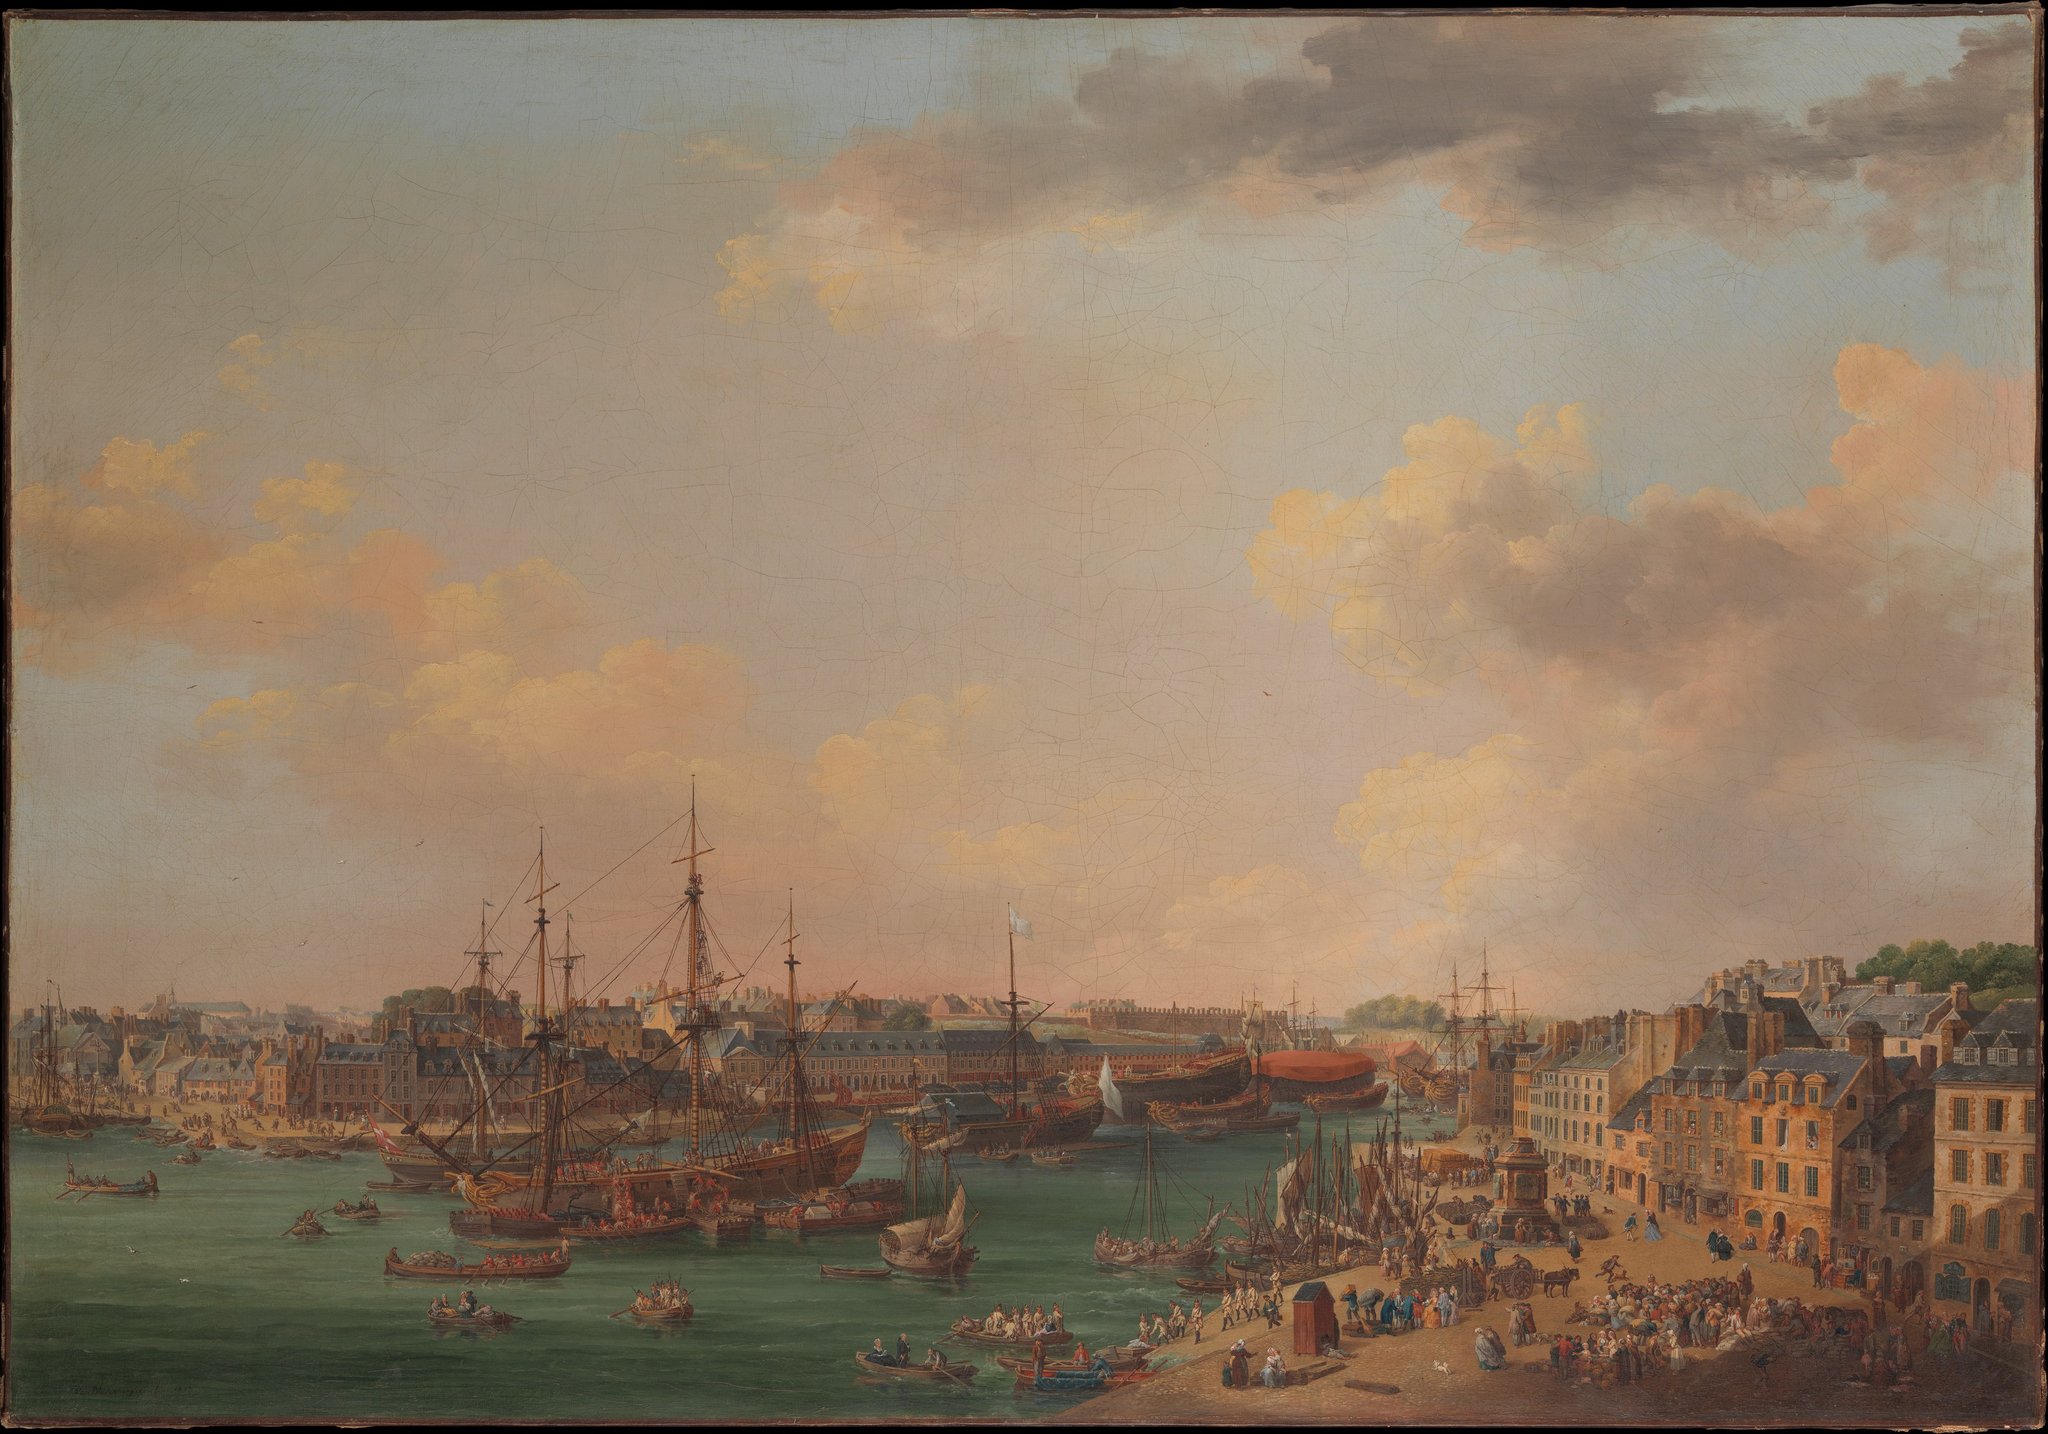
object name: painting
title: The Outer Harbor of Brest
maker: henri joseph van blarenberghe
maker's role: artist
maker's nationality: french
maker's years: 1750-1826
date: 1773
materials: canvas, oil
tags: cities,boats,ships,harbors